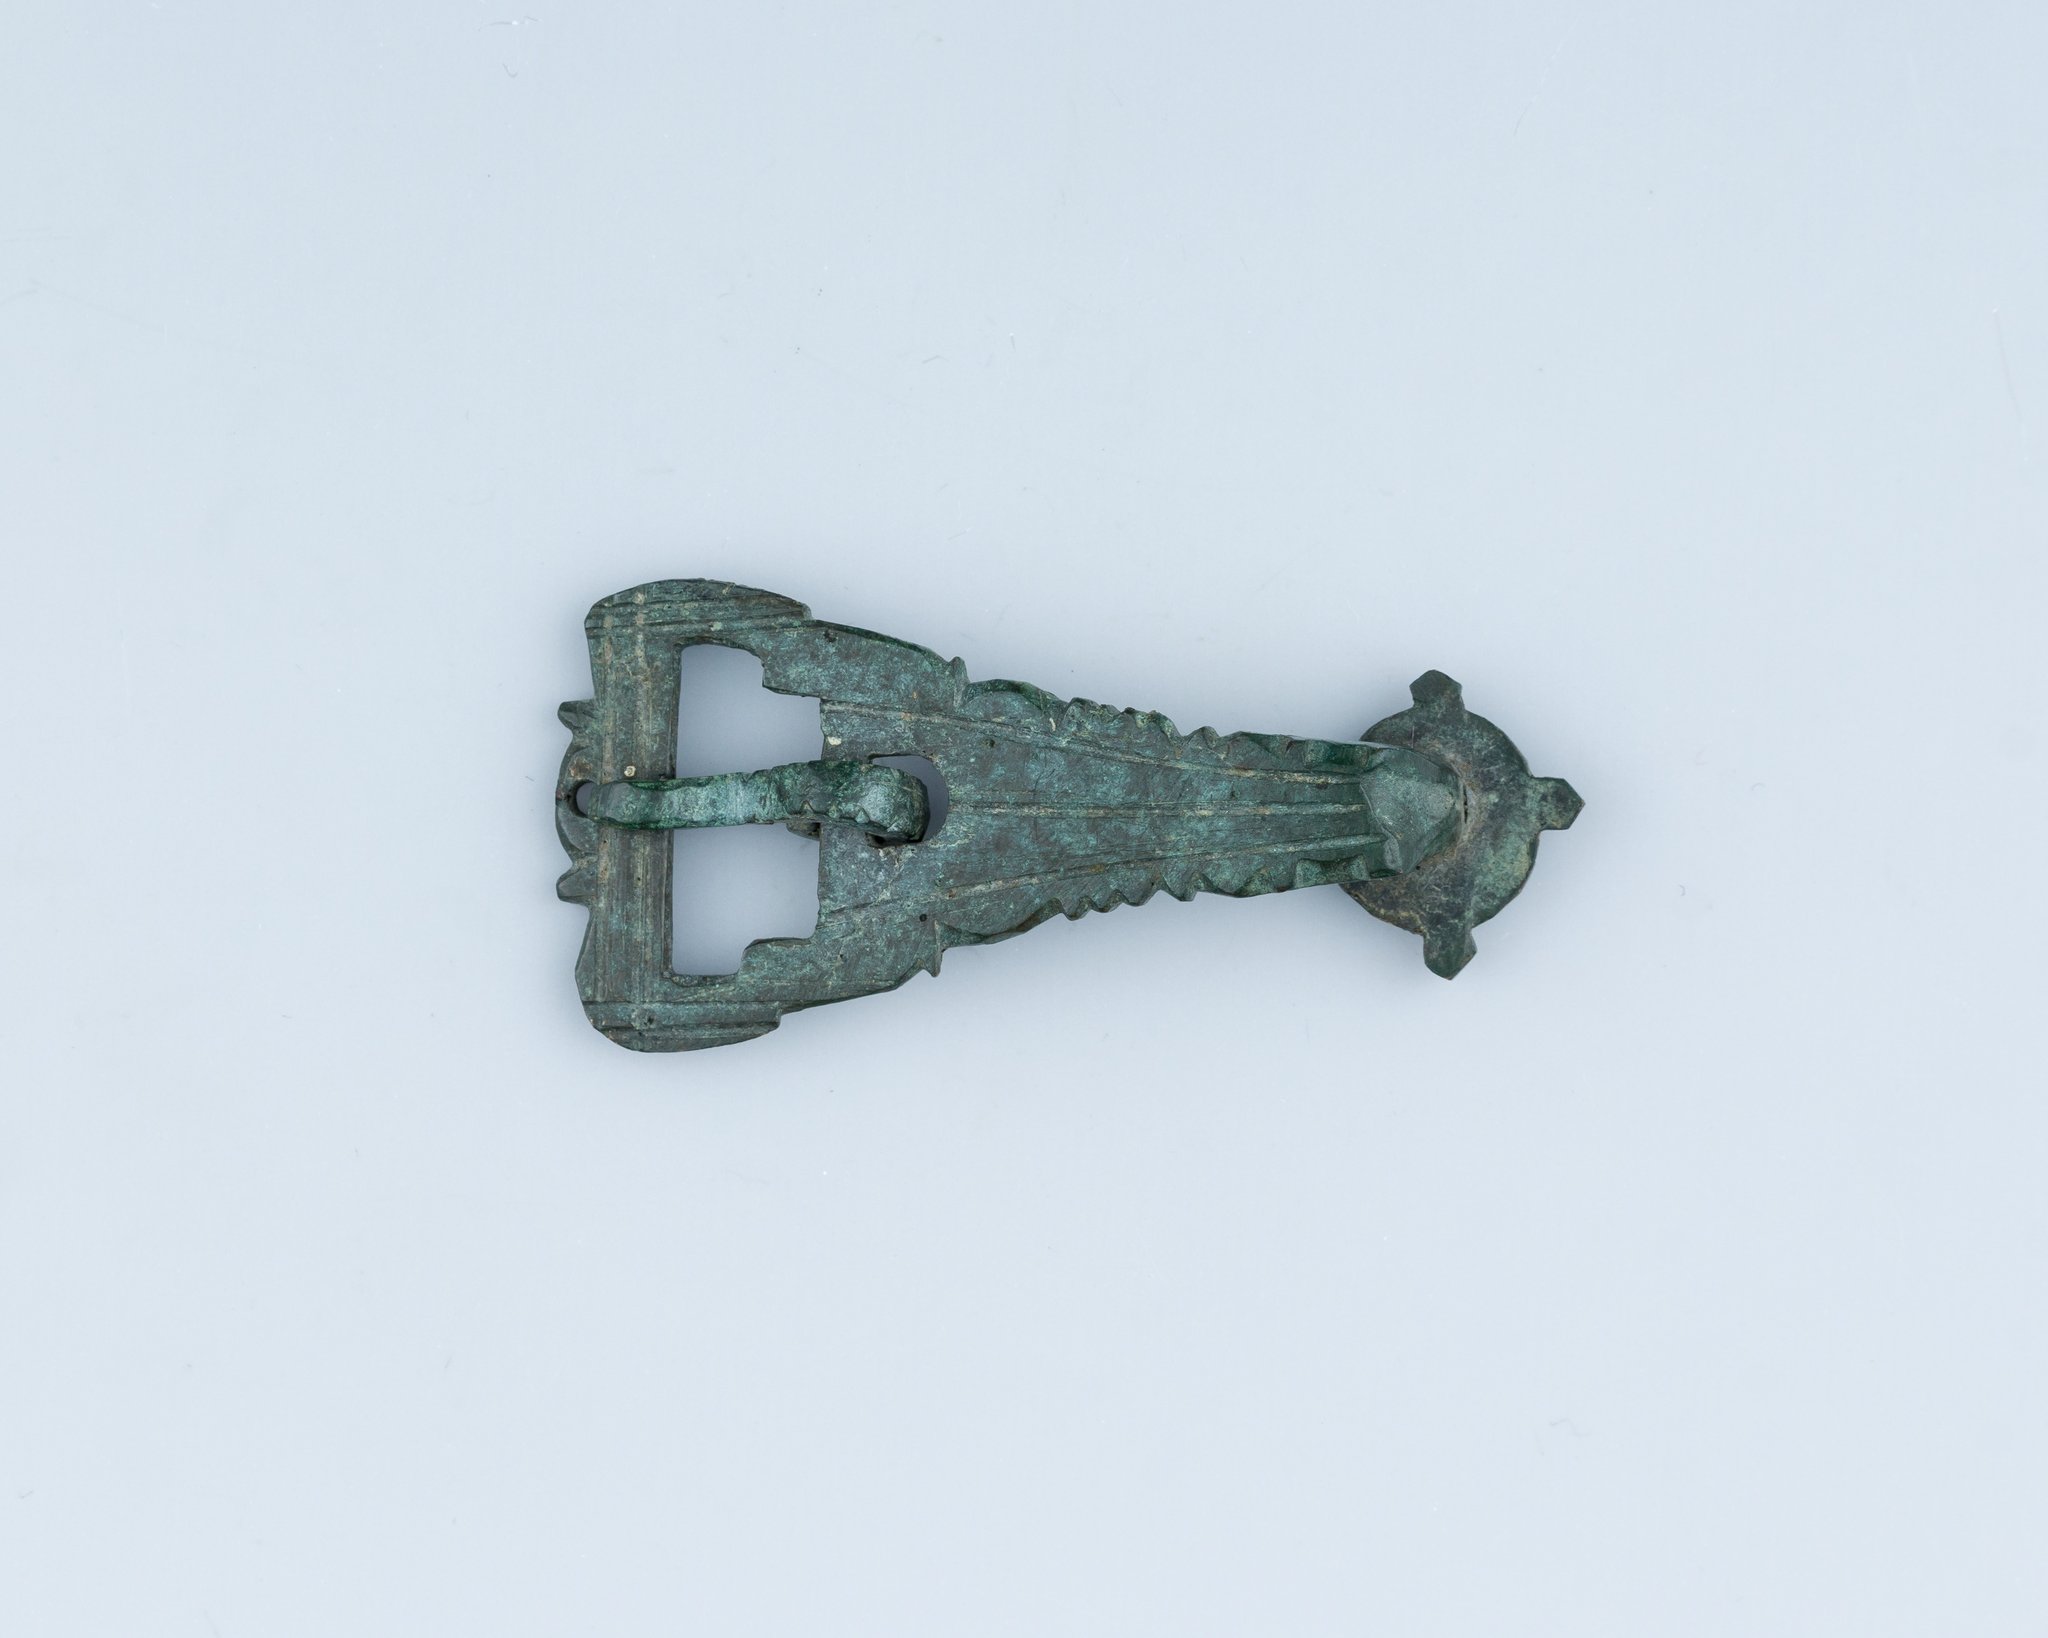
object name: buckle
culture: french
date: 1400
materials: bronze, patina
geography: france